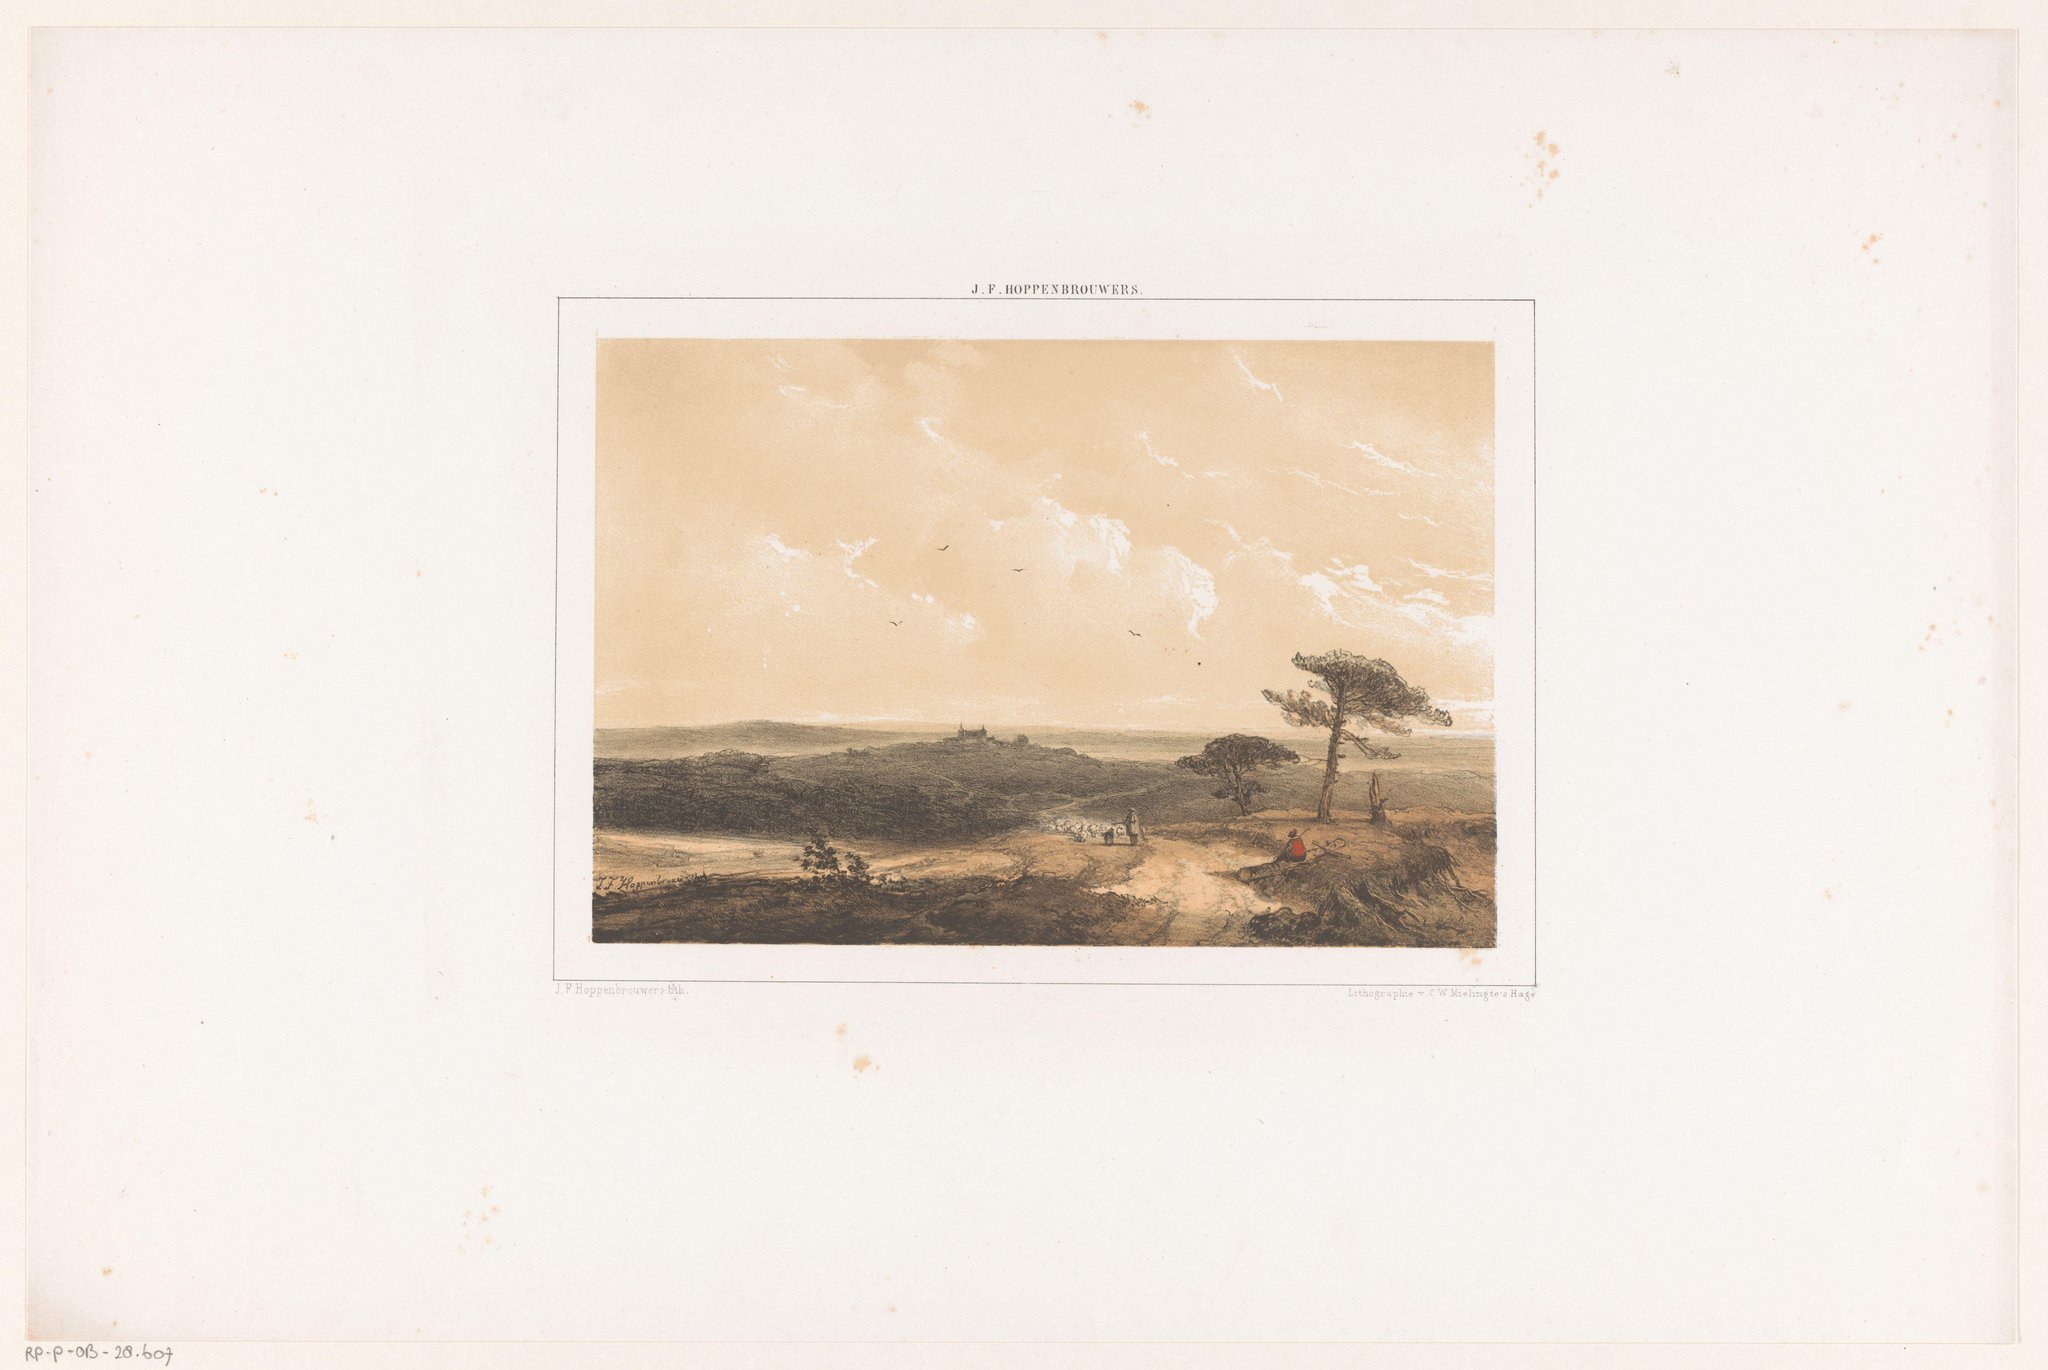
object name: print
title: Heidelandschap met rustende wandelaar en herder met kudde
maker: johannes franciscus hoppenbrouwers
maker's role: draughtsman, painter, print maker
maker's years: 1819-1866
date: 1847-1863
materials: paper, watercolor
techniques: brush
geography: the hague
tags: sitting figure, herding, herdsman, herdswoman, shepherd, shepherdess, cowherd, etc., herd, flock, plain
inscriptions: collector's mark: Lugt 2228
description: De wandelaar zit op een boomstronk. De herder loopt samen met zijn hond achter zijn kudde schapen.